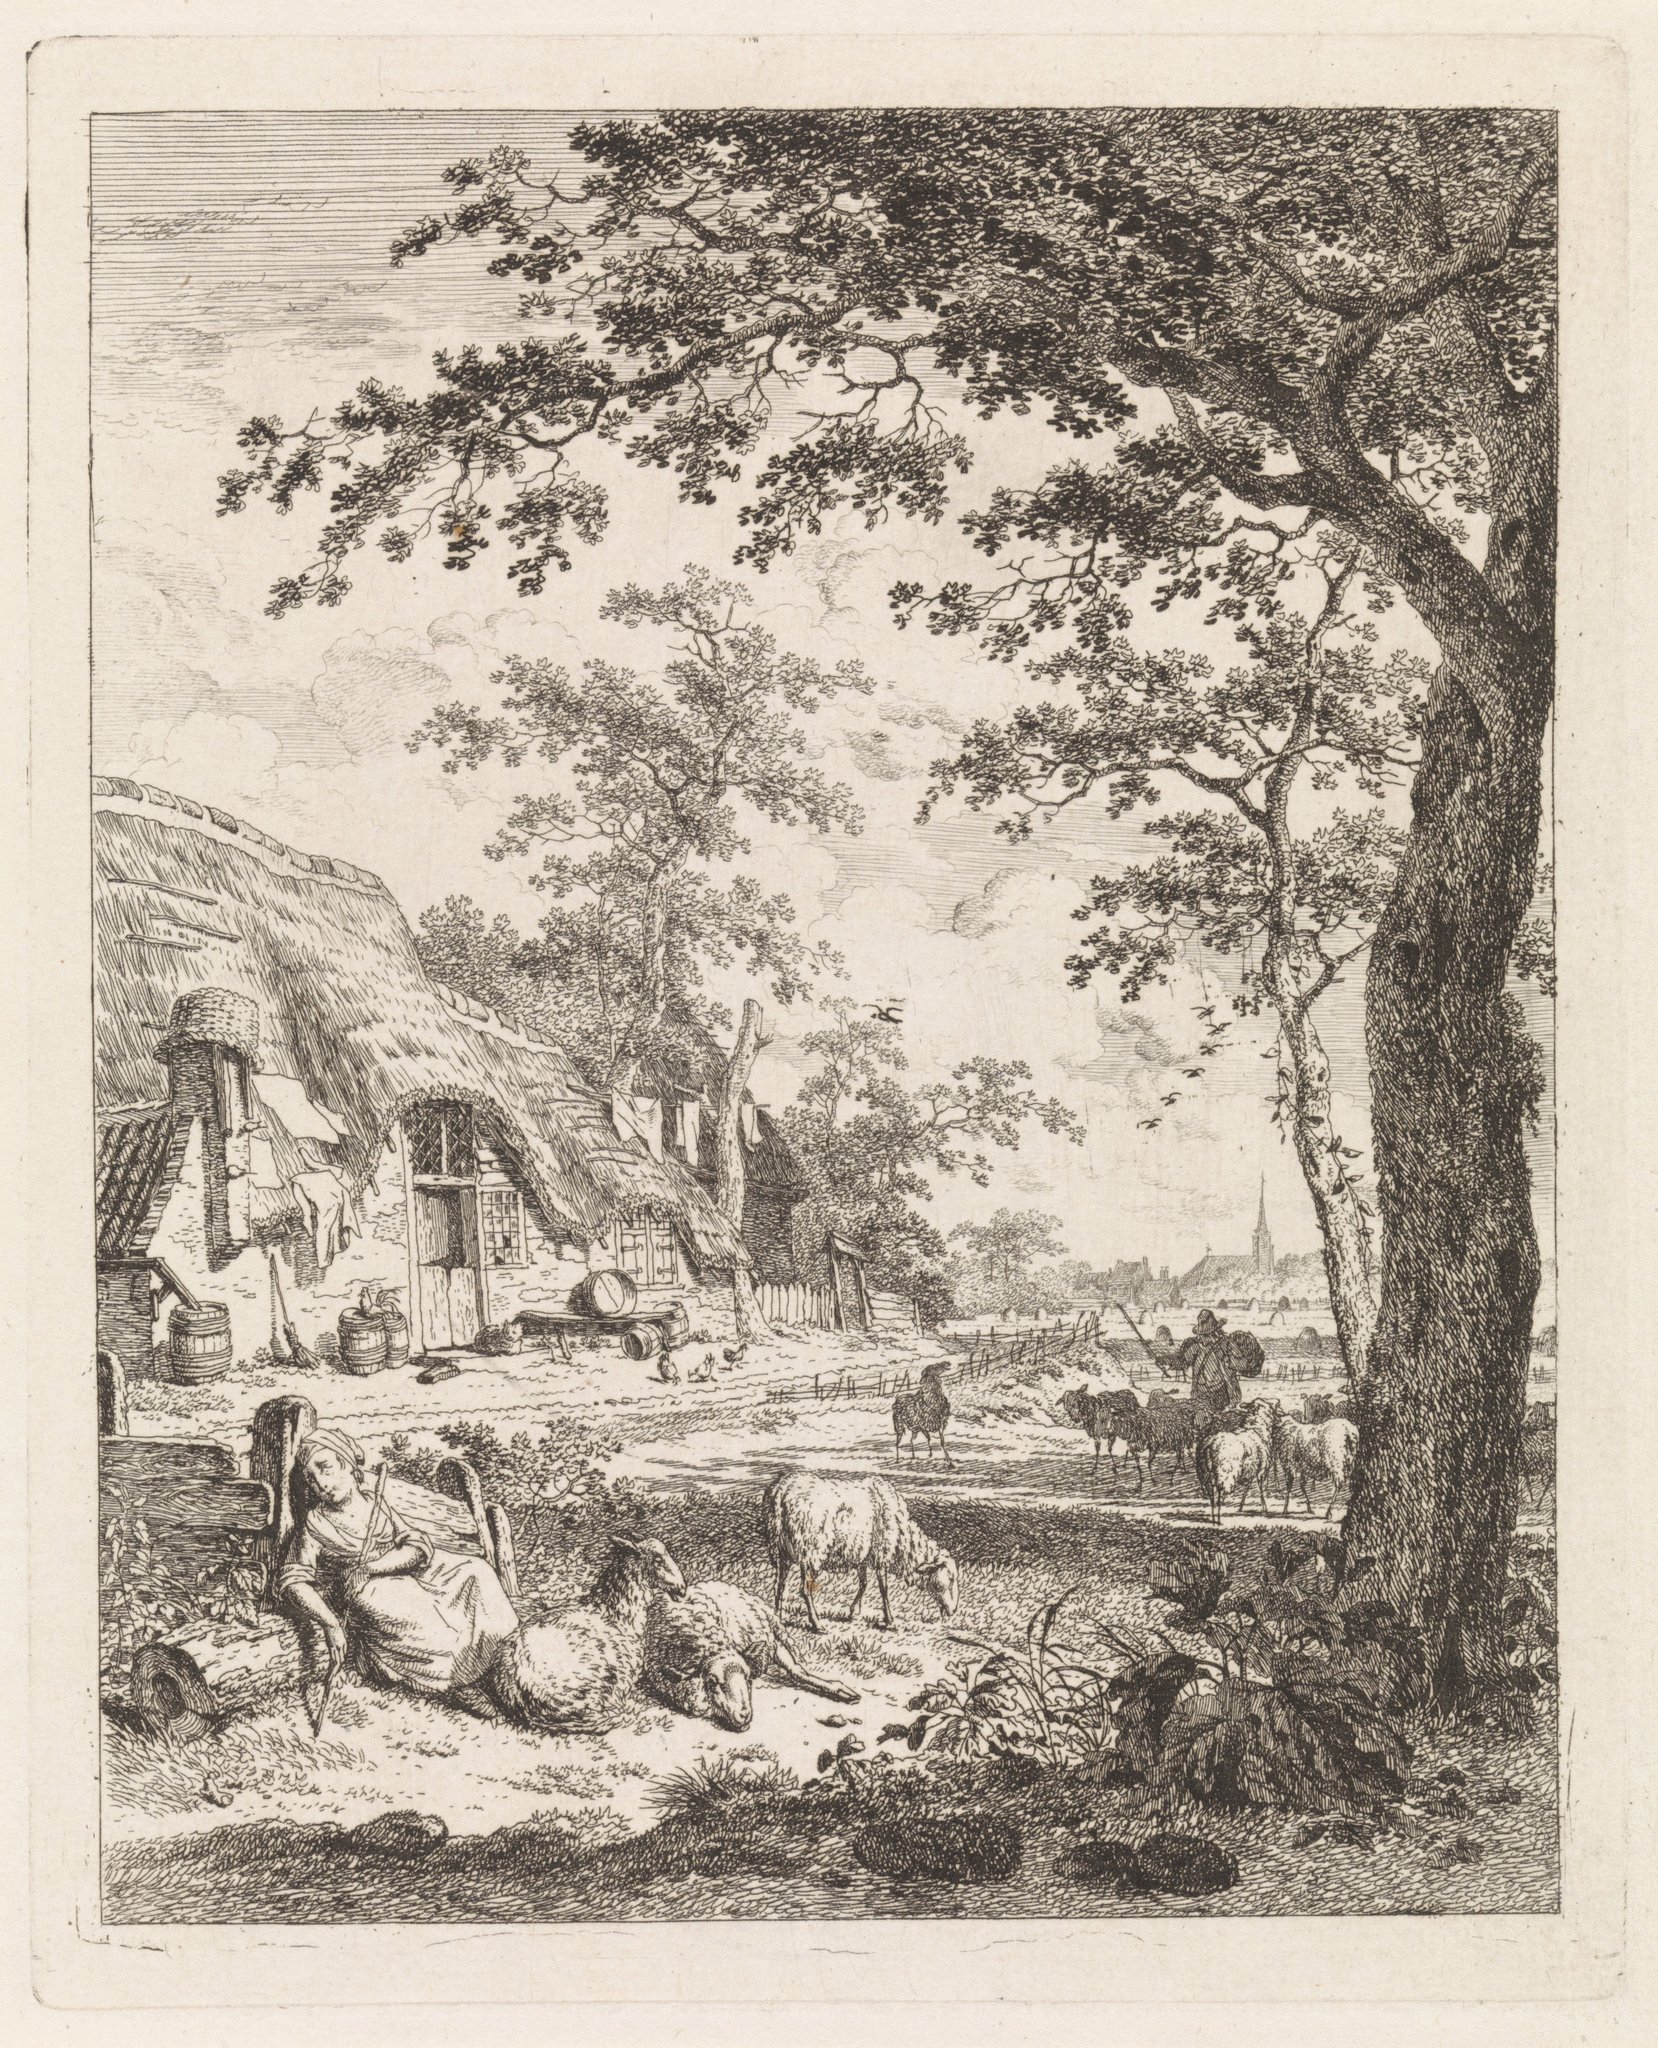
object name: print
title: Herderin met schapen voor een boerderij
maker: leendert overbeek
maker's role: draughtsman, painter, print maker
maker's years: 1752-1815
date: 1791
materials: paper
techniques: etching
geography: haarlem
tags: herding, herdsman, herdswoman, shepherd, shepherdess, cowherd, etc.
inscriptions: collector's mark: Lugt 2228